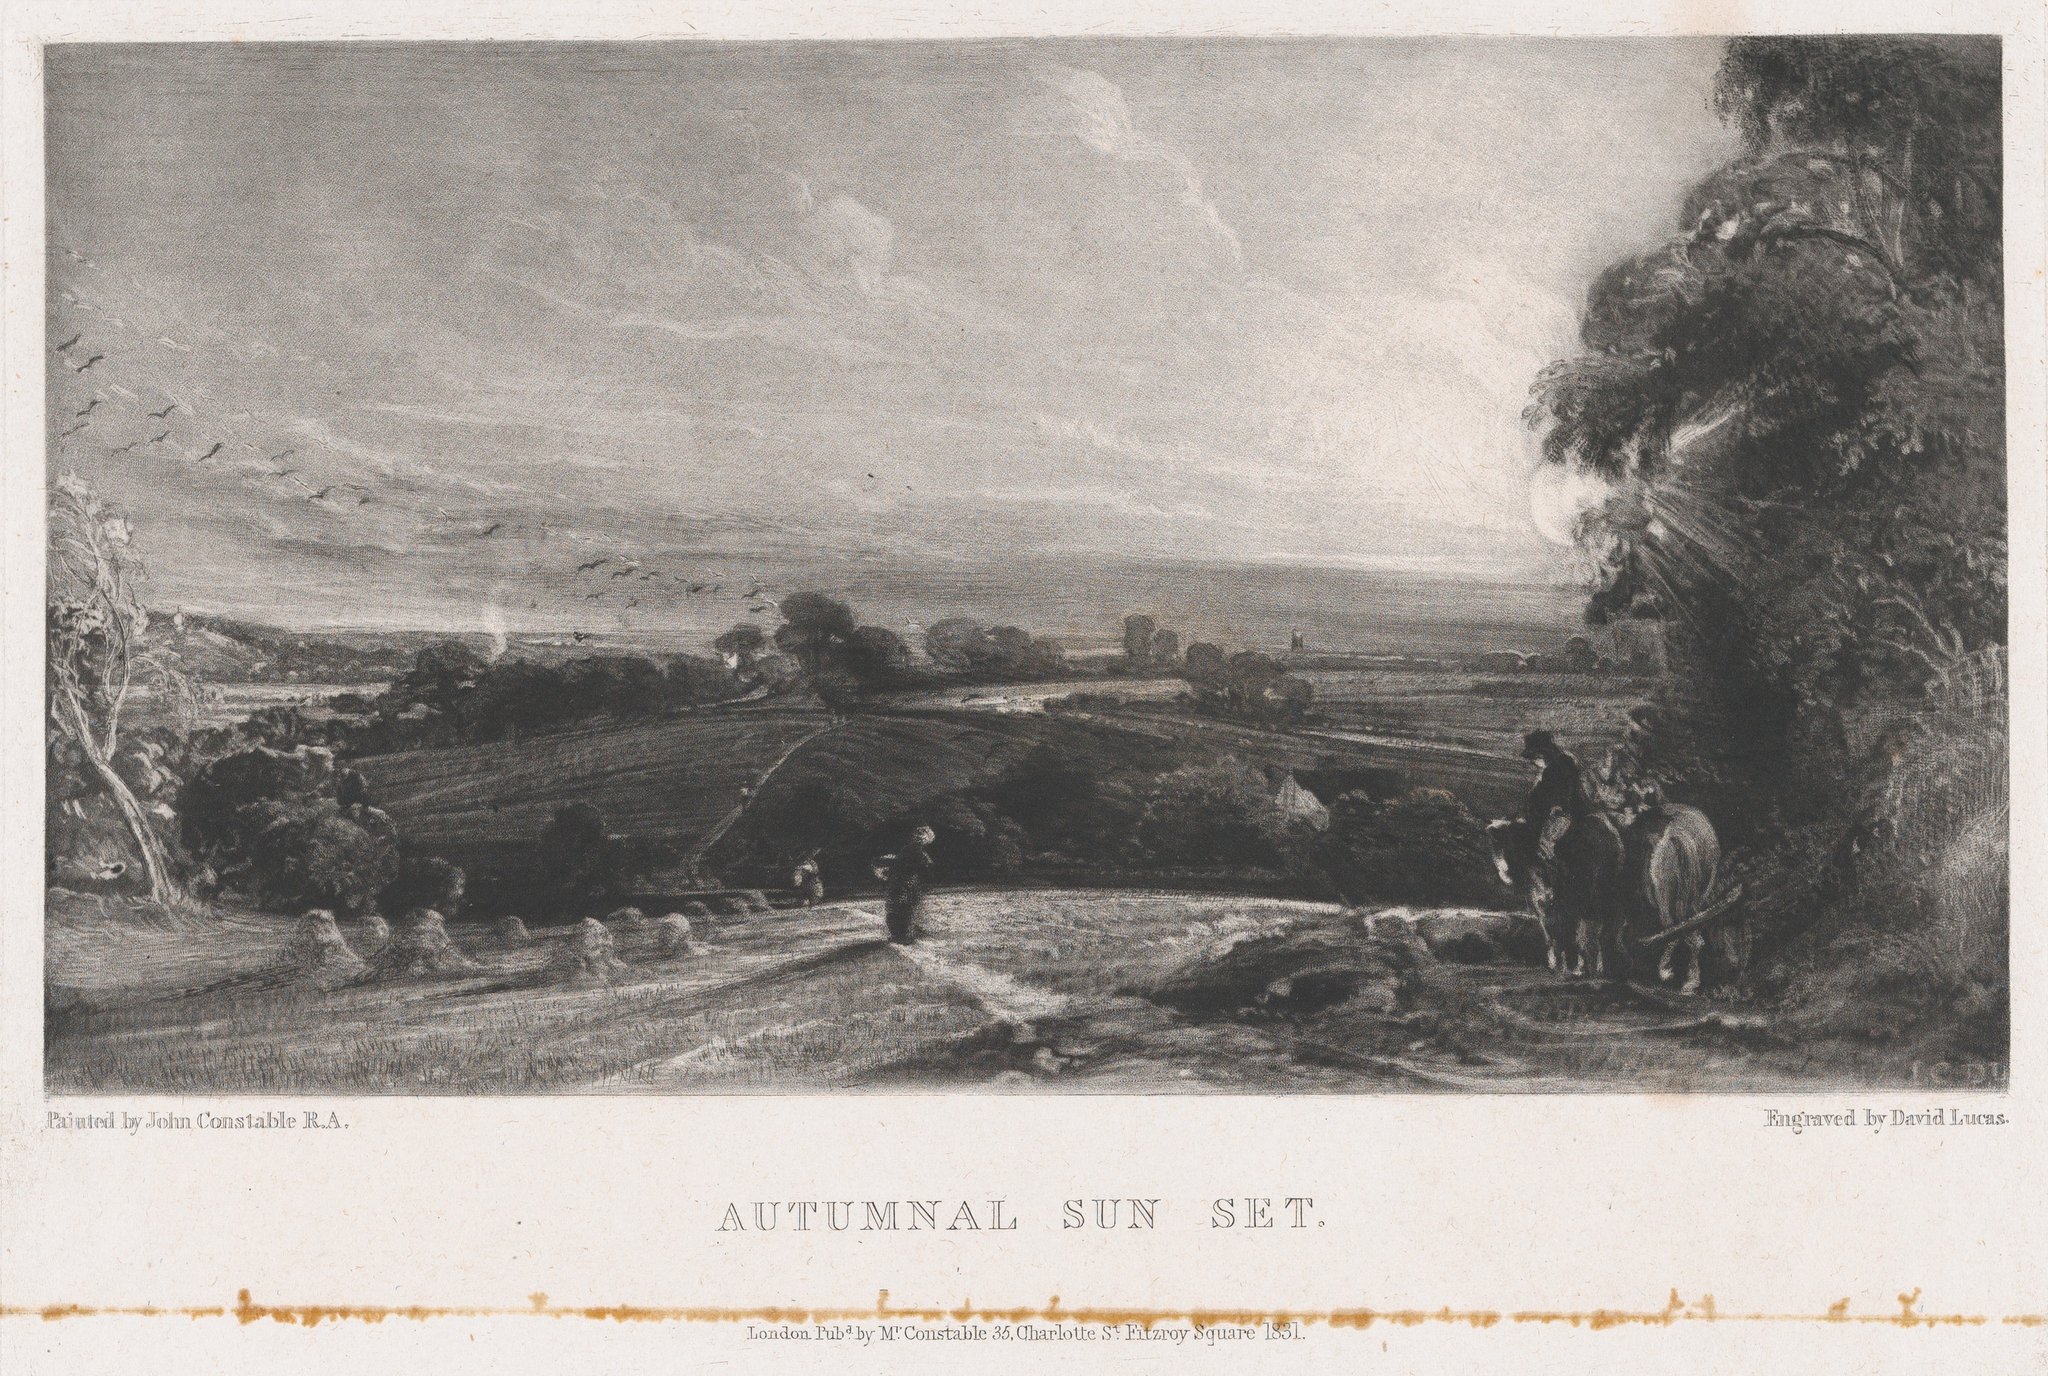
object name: print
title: Autumnal Sunset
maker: david lucas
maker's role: artist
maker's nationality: british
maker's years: 1802-1881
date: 1831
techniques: mezzotint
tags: men,horses,autumn,evening